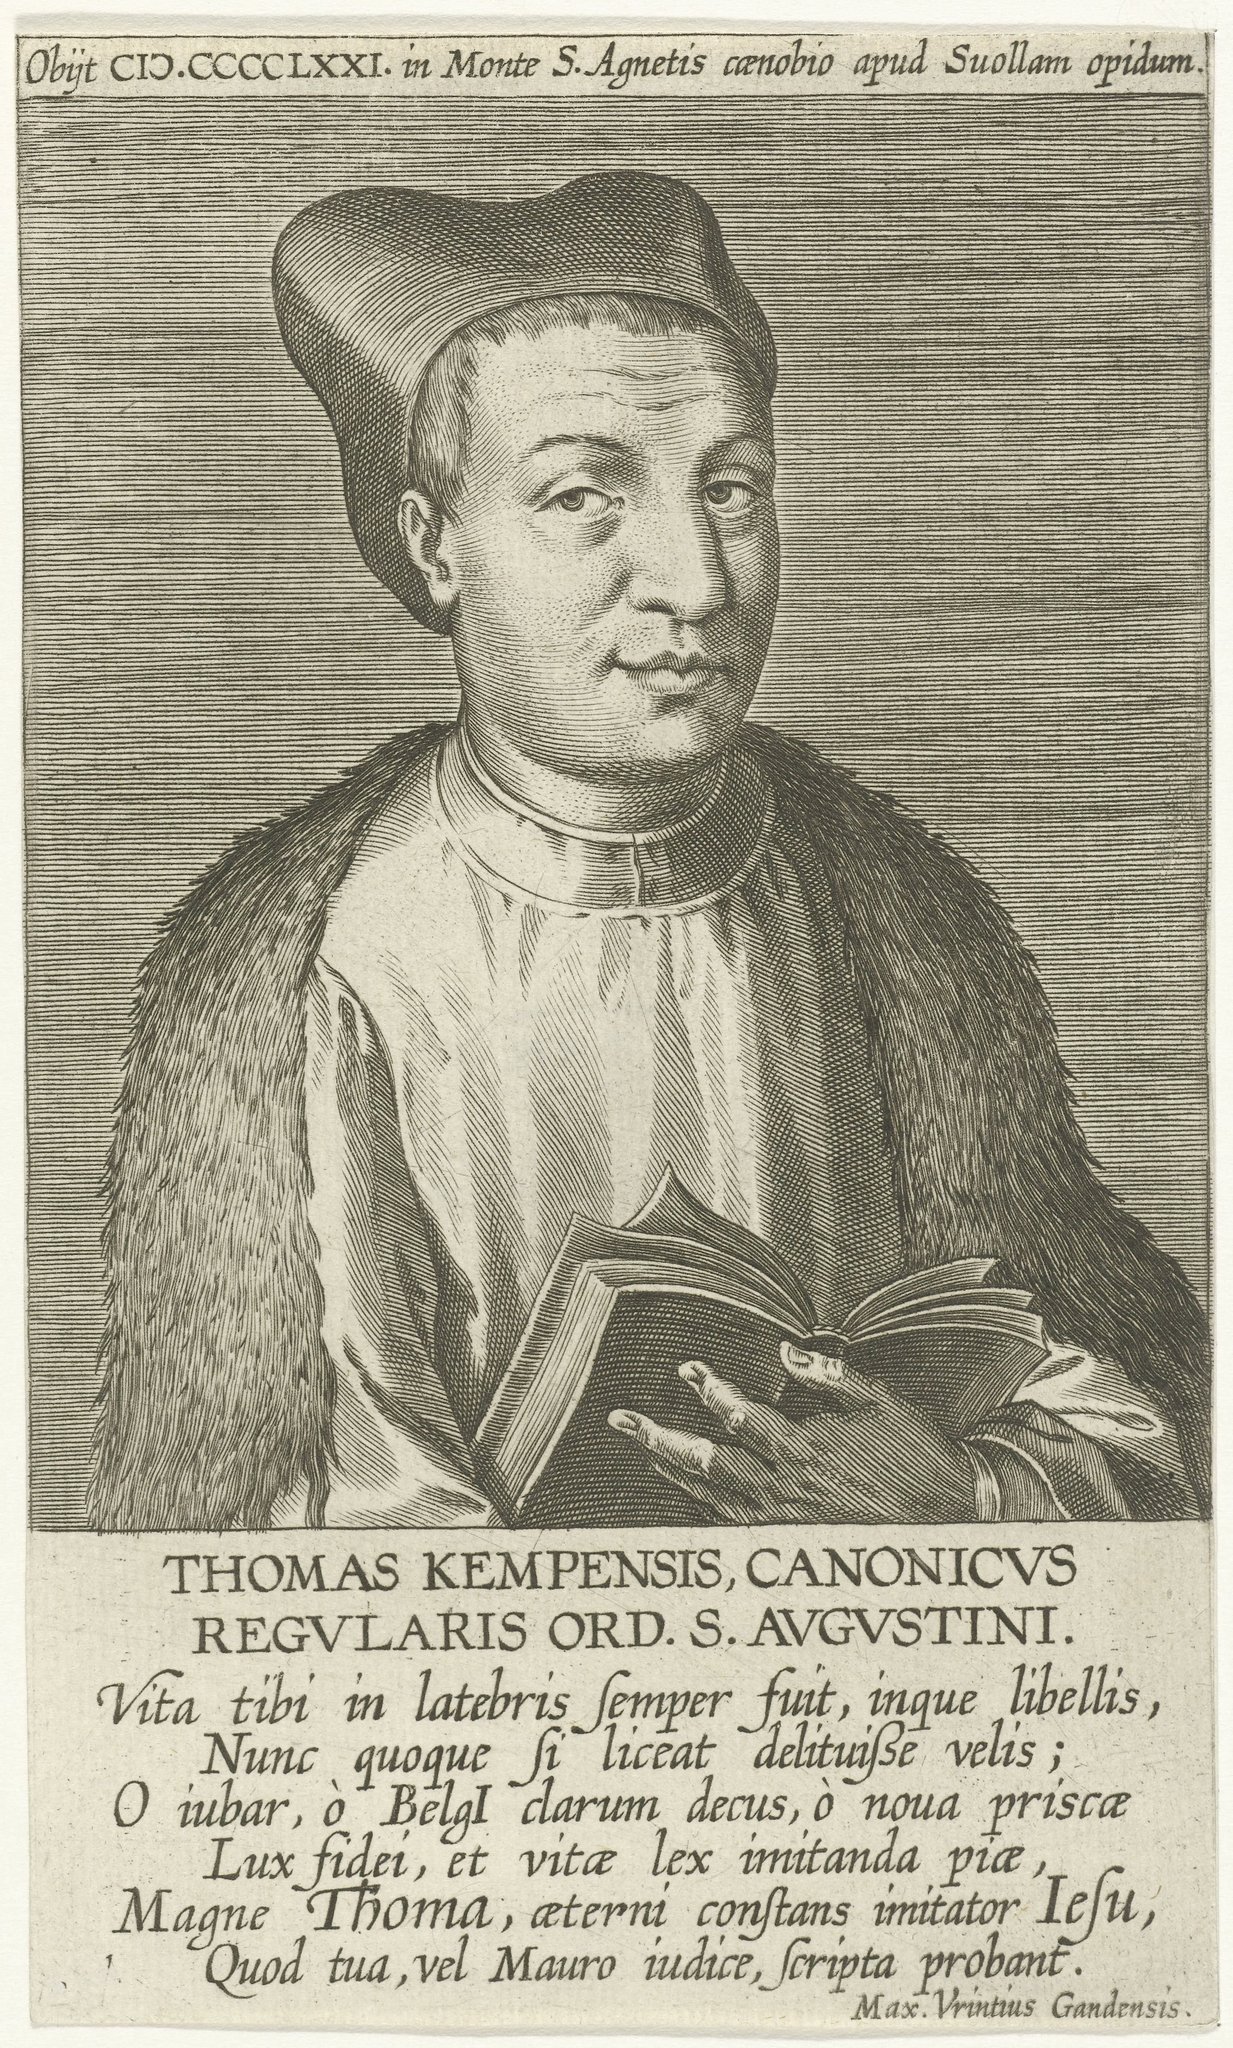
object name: print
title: Thomas Kempensis Canonicvs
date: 1604-1608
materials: paper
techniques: engraving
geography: ghent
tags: priest, thomas à kempis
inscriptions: collector's mark: Lugt 2228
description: Portret van Thomas à Kempis. Buste naar rechts. De prent heeft een Latijns boven- en onderschrift en maakt deel uit van een serie van beroemde Nederlandse en Vlaamse geleerden.